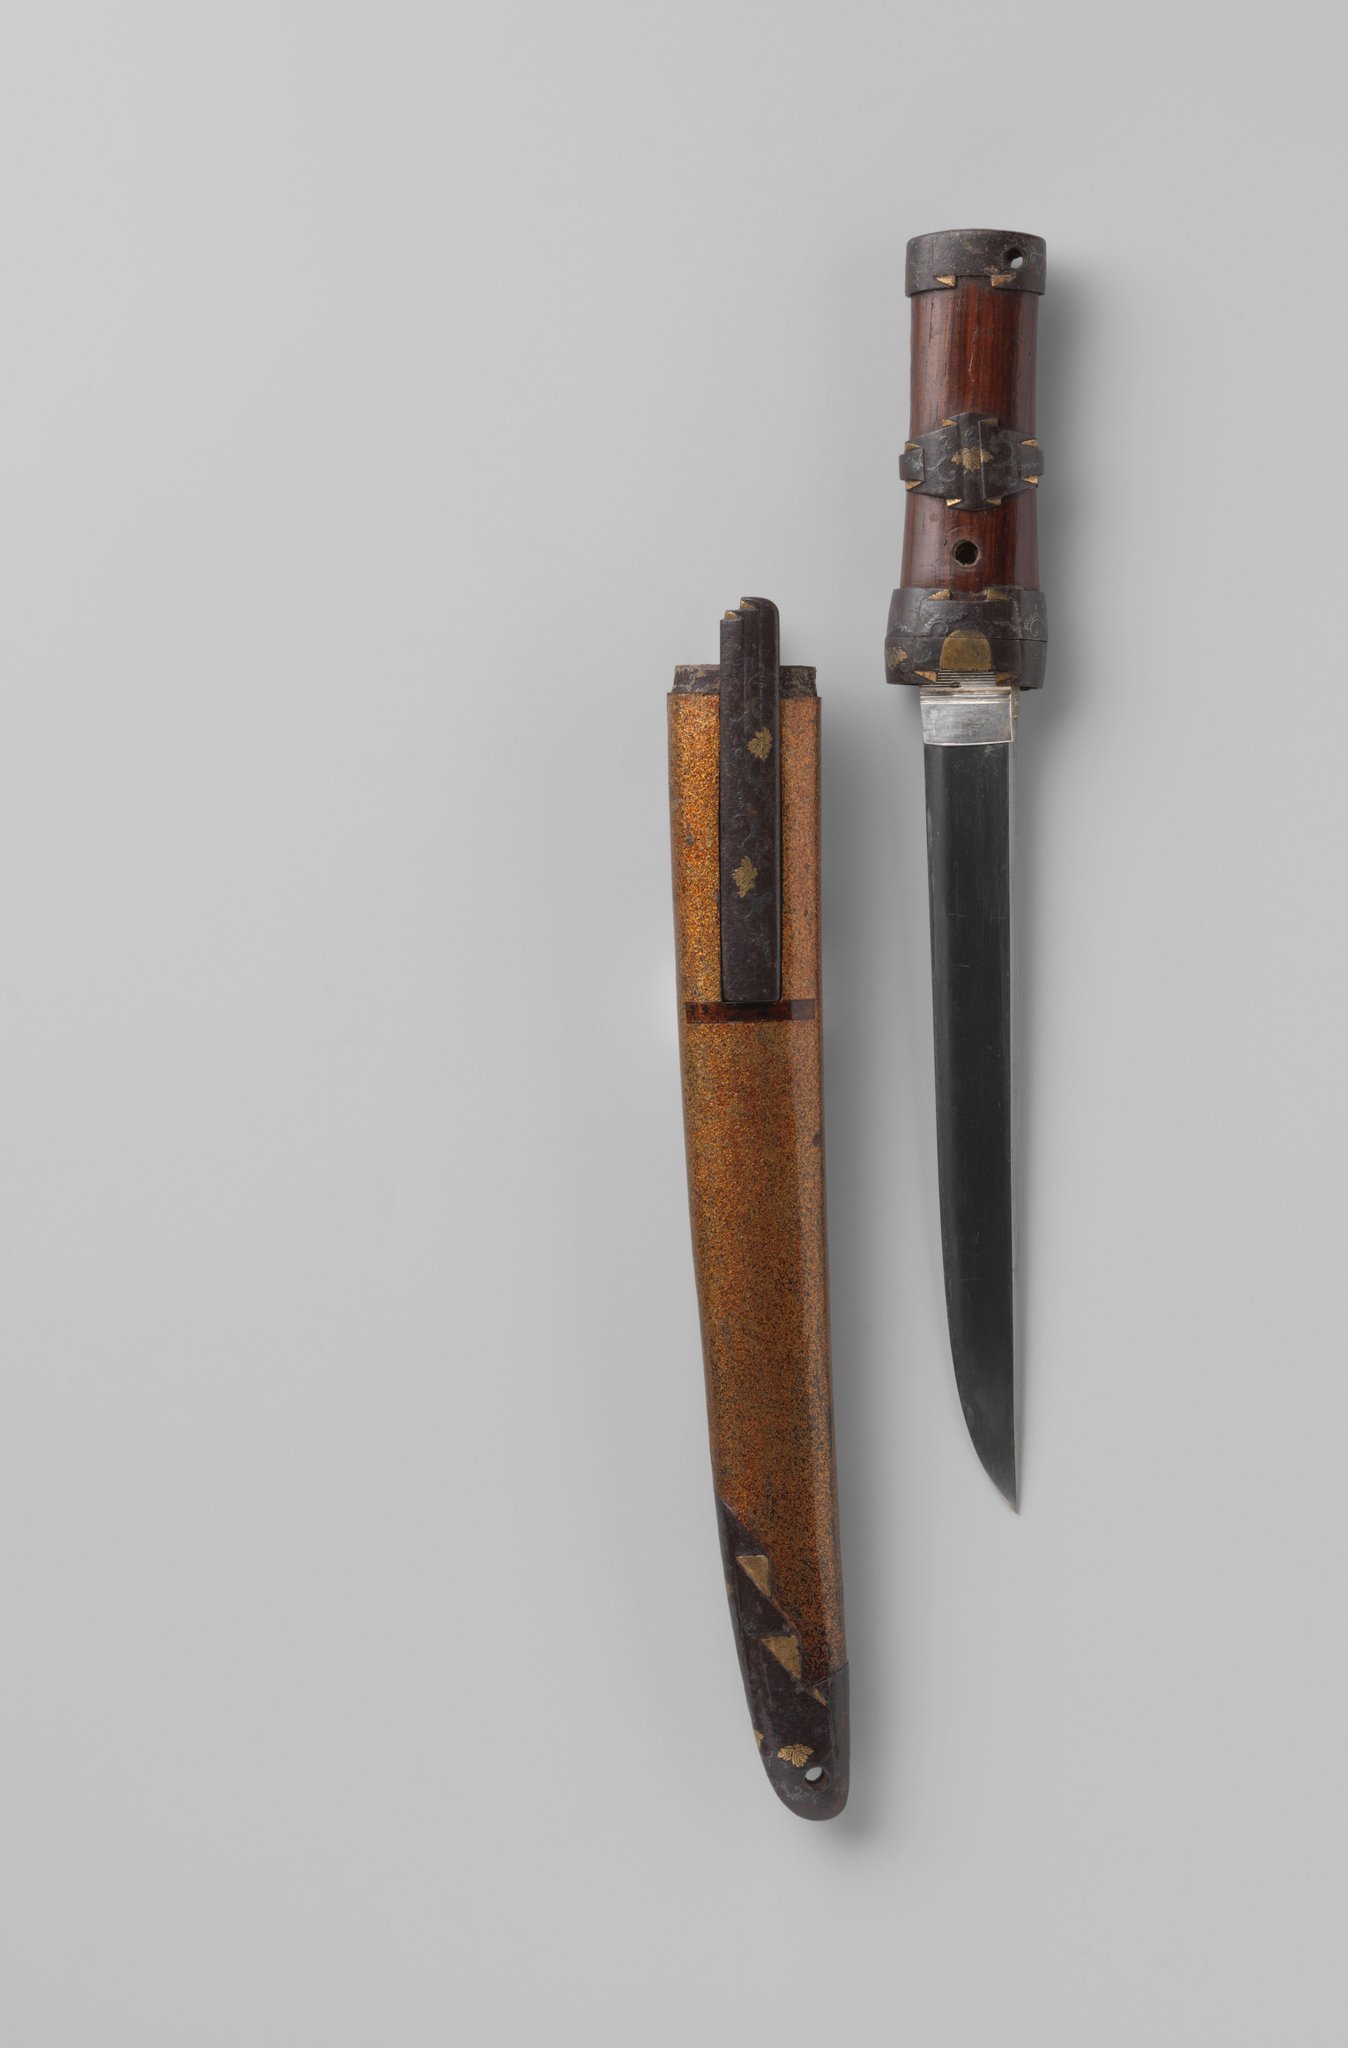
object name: dagger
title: Dolk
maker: kunihiro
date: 1600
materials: gold, silver, steel, wood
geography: japan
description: Dolk waarvan schede en beslagstukken van de greep met goud en zilver geincrustreerd zijn, alsook de kozuka en de kogai.